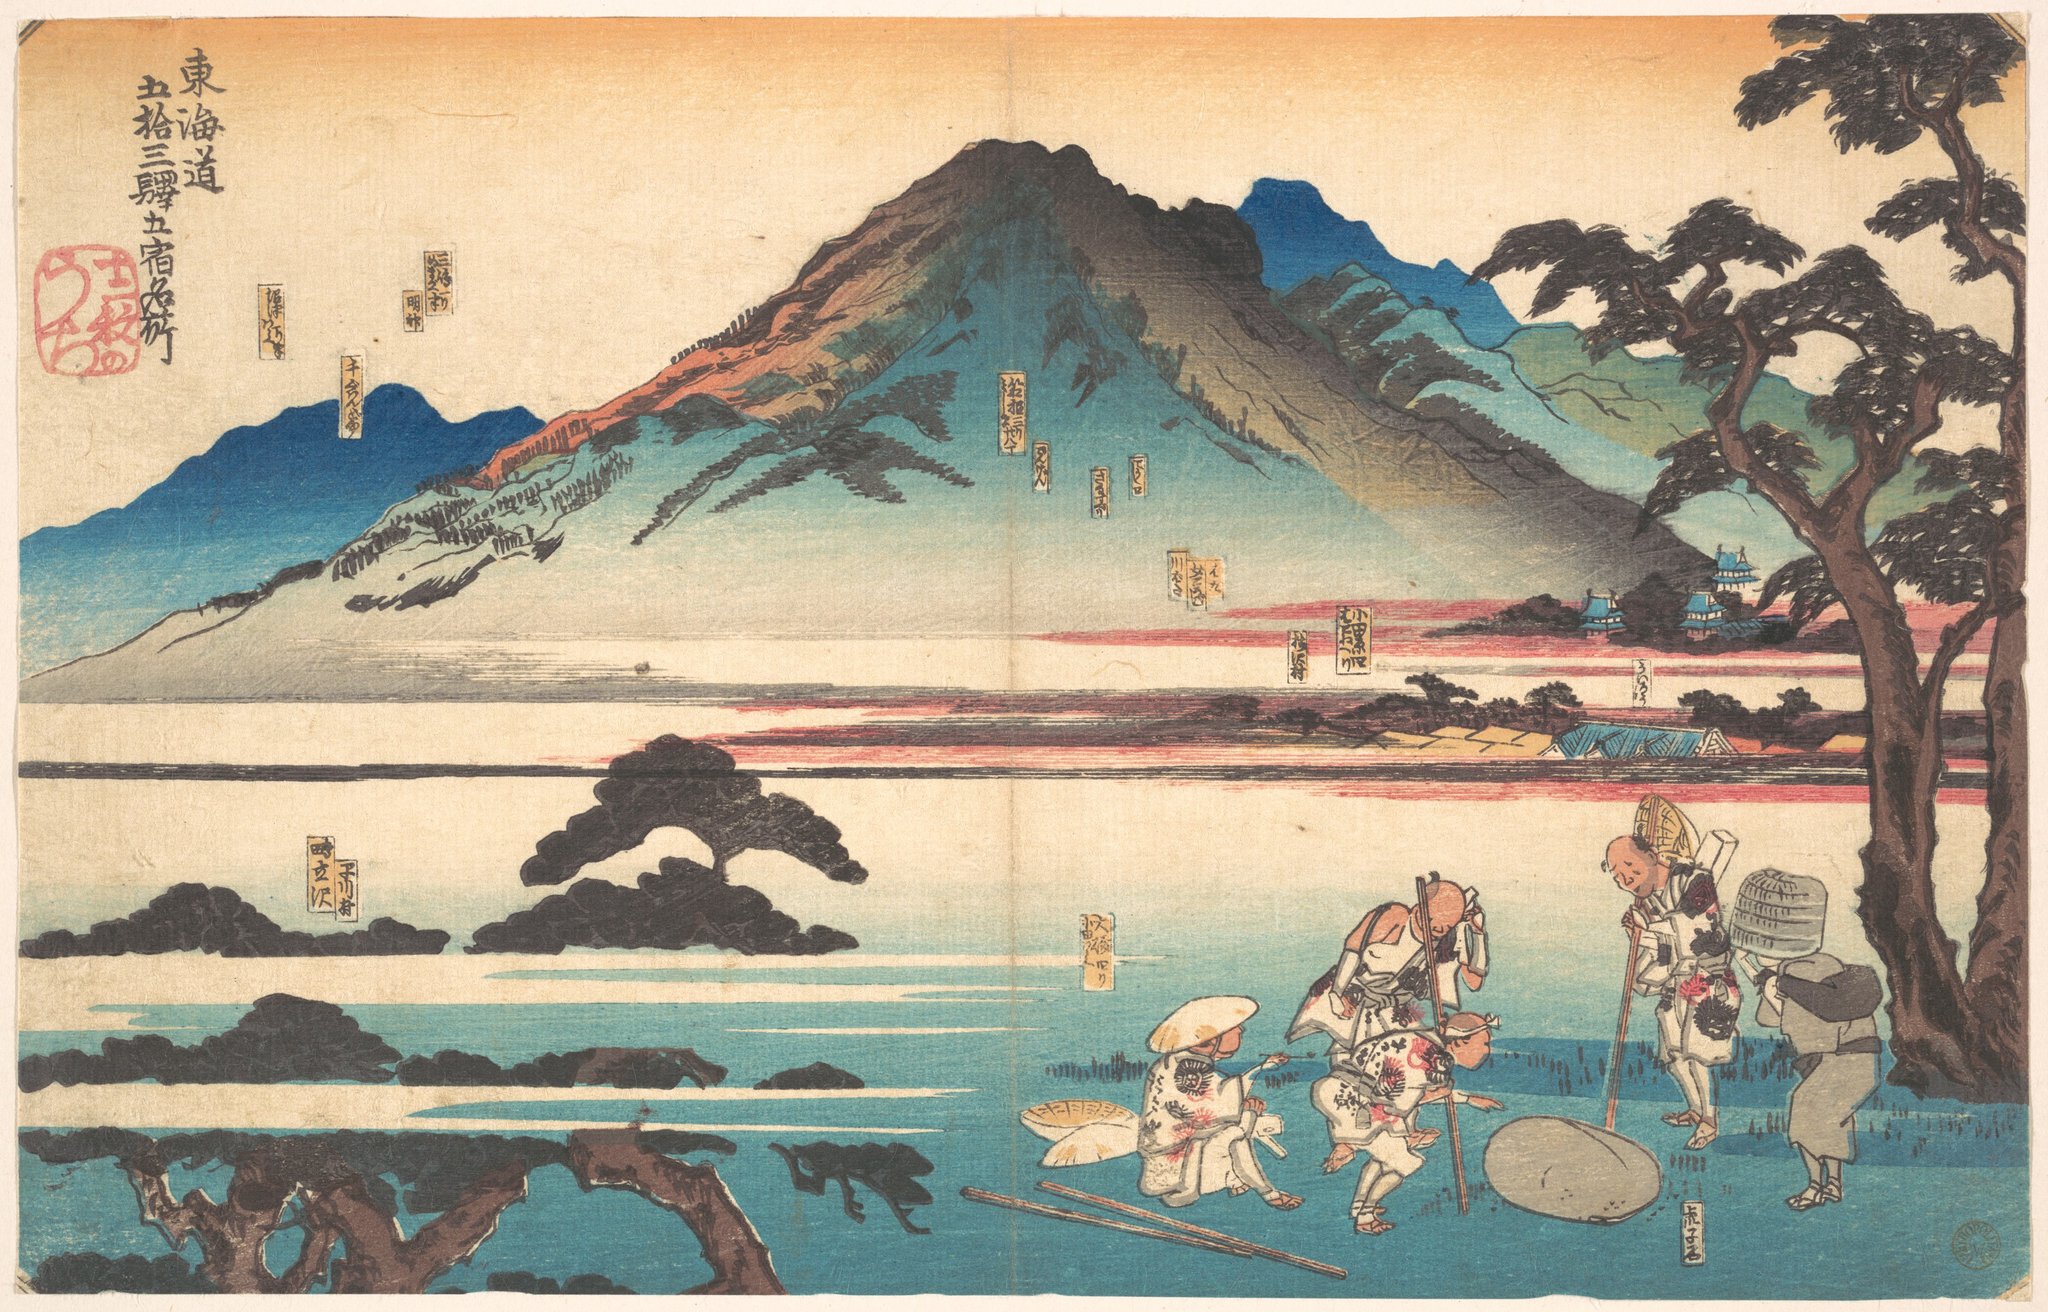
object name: print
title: Oiso, Odawara, Hakone, Mishima, Numazu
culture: japanese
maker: utagawa kuniyoshi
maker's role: artist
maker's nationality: japanese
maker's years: 1797-1861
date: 1840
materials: ink, paper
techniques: woodblock print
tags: men,mountains,trees